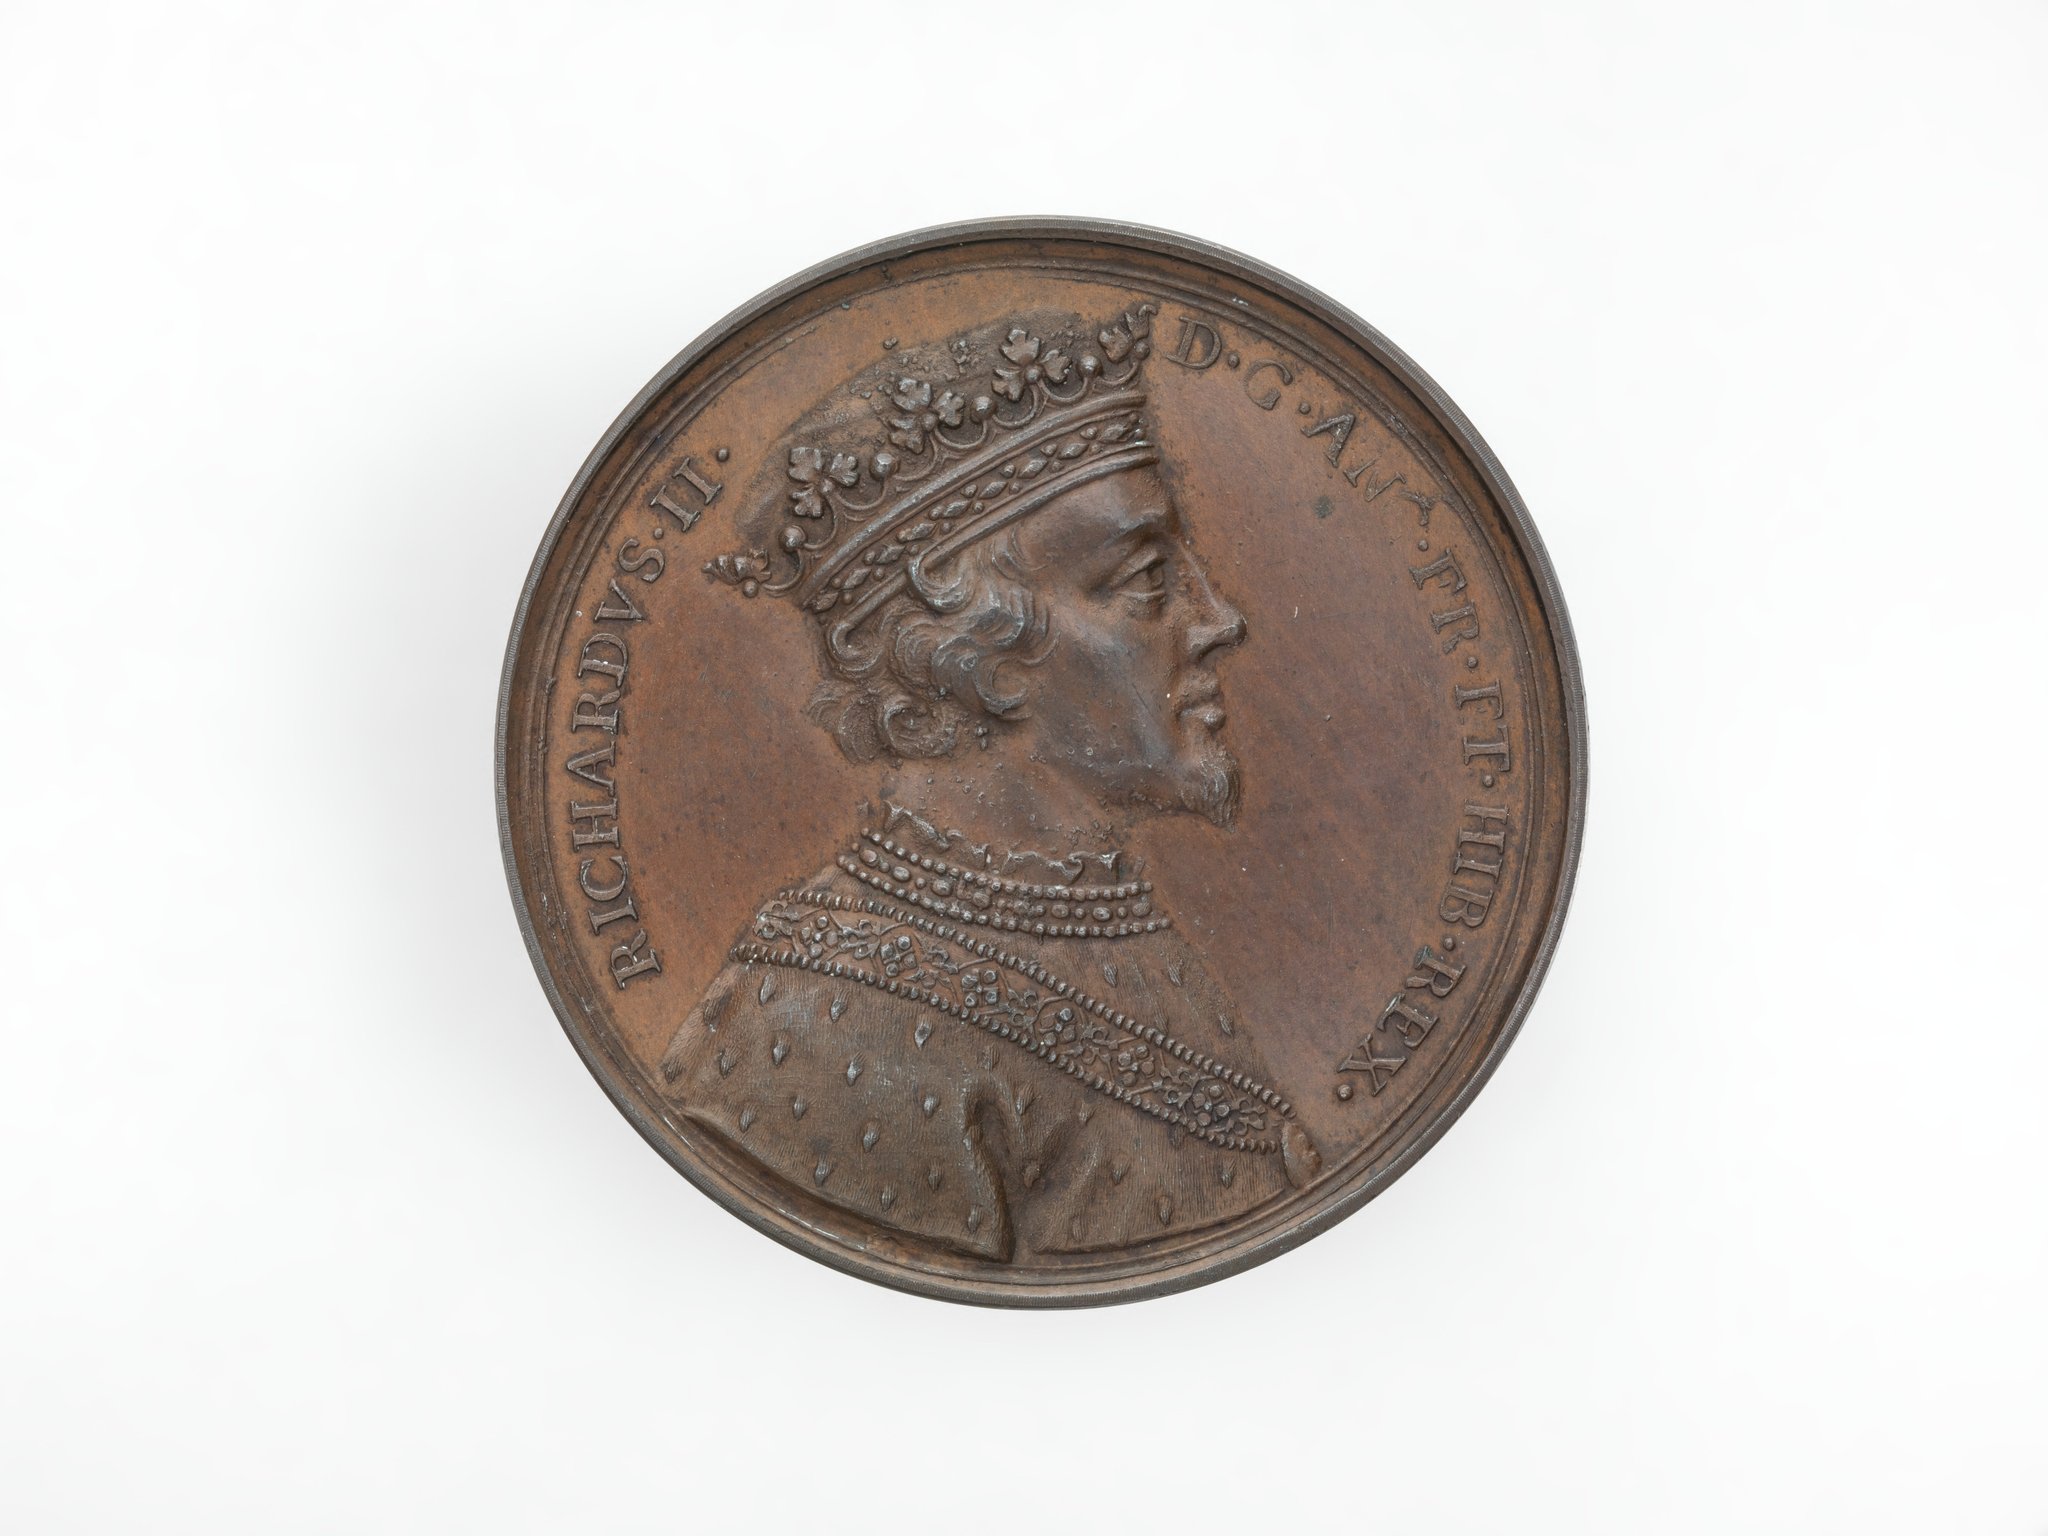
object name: medal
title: Richard II, from the English Monarchs series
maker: jean dassier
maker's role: artist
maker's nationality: swiss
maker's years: 1676-1763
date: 1731-1732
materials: bronze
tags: kings,profiles